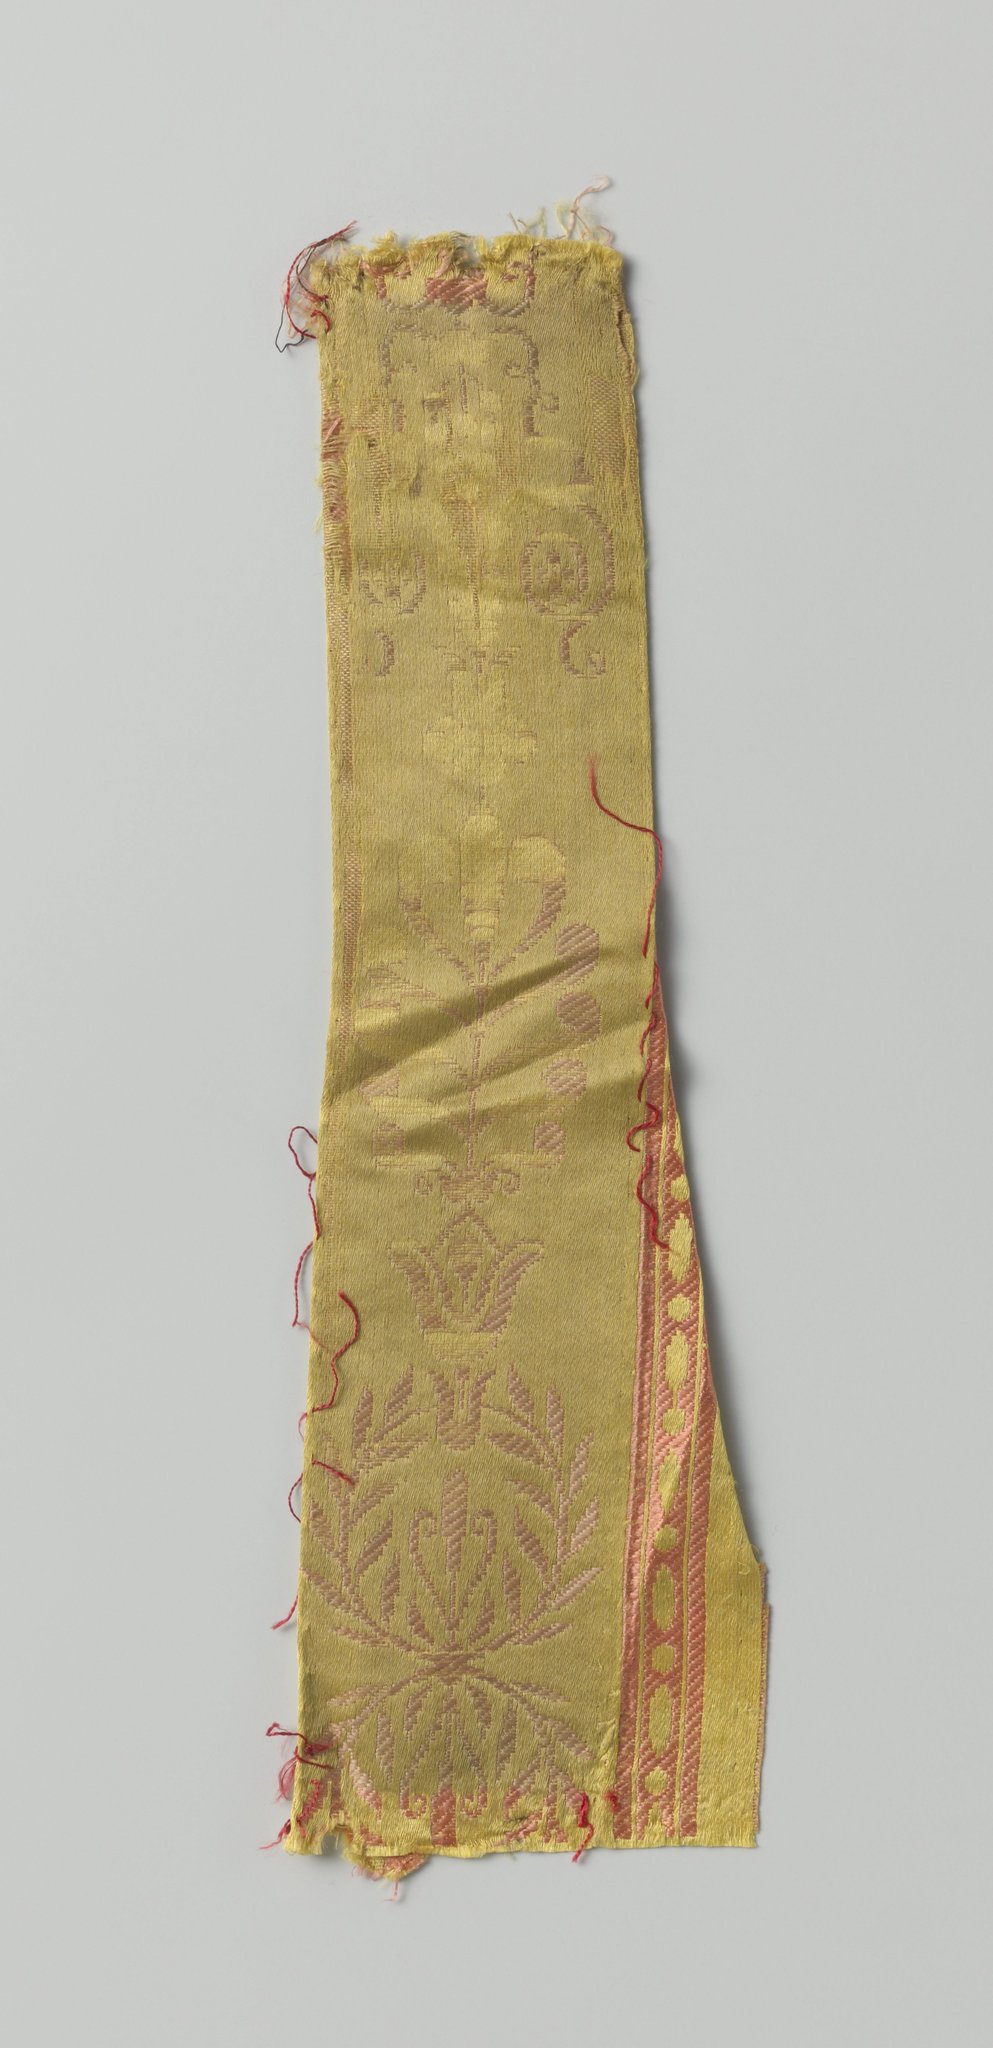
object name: stoelbekleding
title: Fragment zijdeweefsel van een stoelbekleding.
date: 1805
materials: silk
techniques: brocade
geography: france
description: Fragment geel zijdeweefsel, van een stoelbekleding. Het patroon heeft op een gele grond roze palmetten en arabesken. Het fragment hoort bij dertien fragmenten met invnr. BK-1992-18-A t/m BK-1992-18-M.